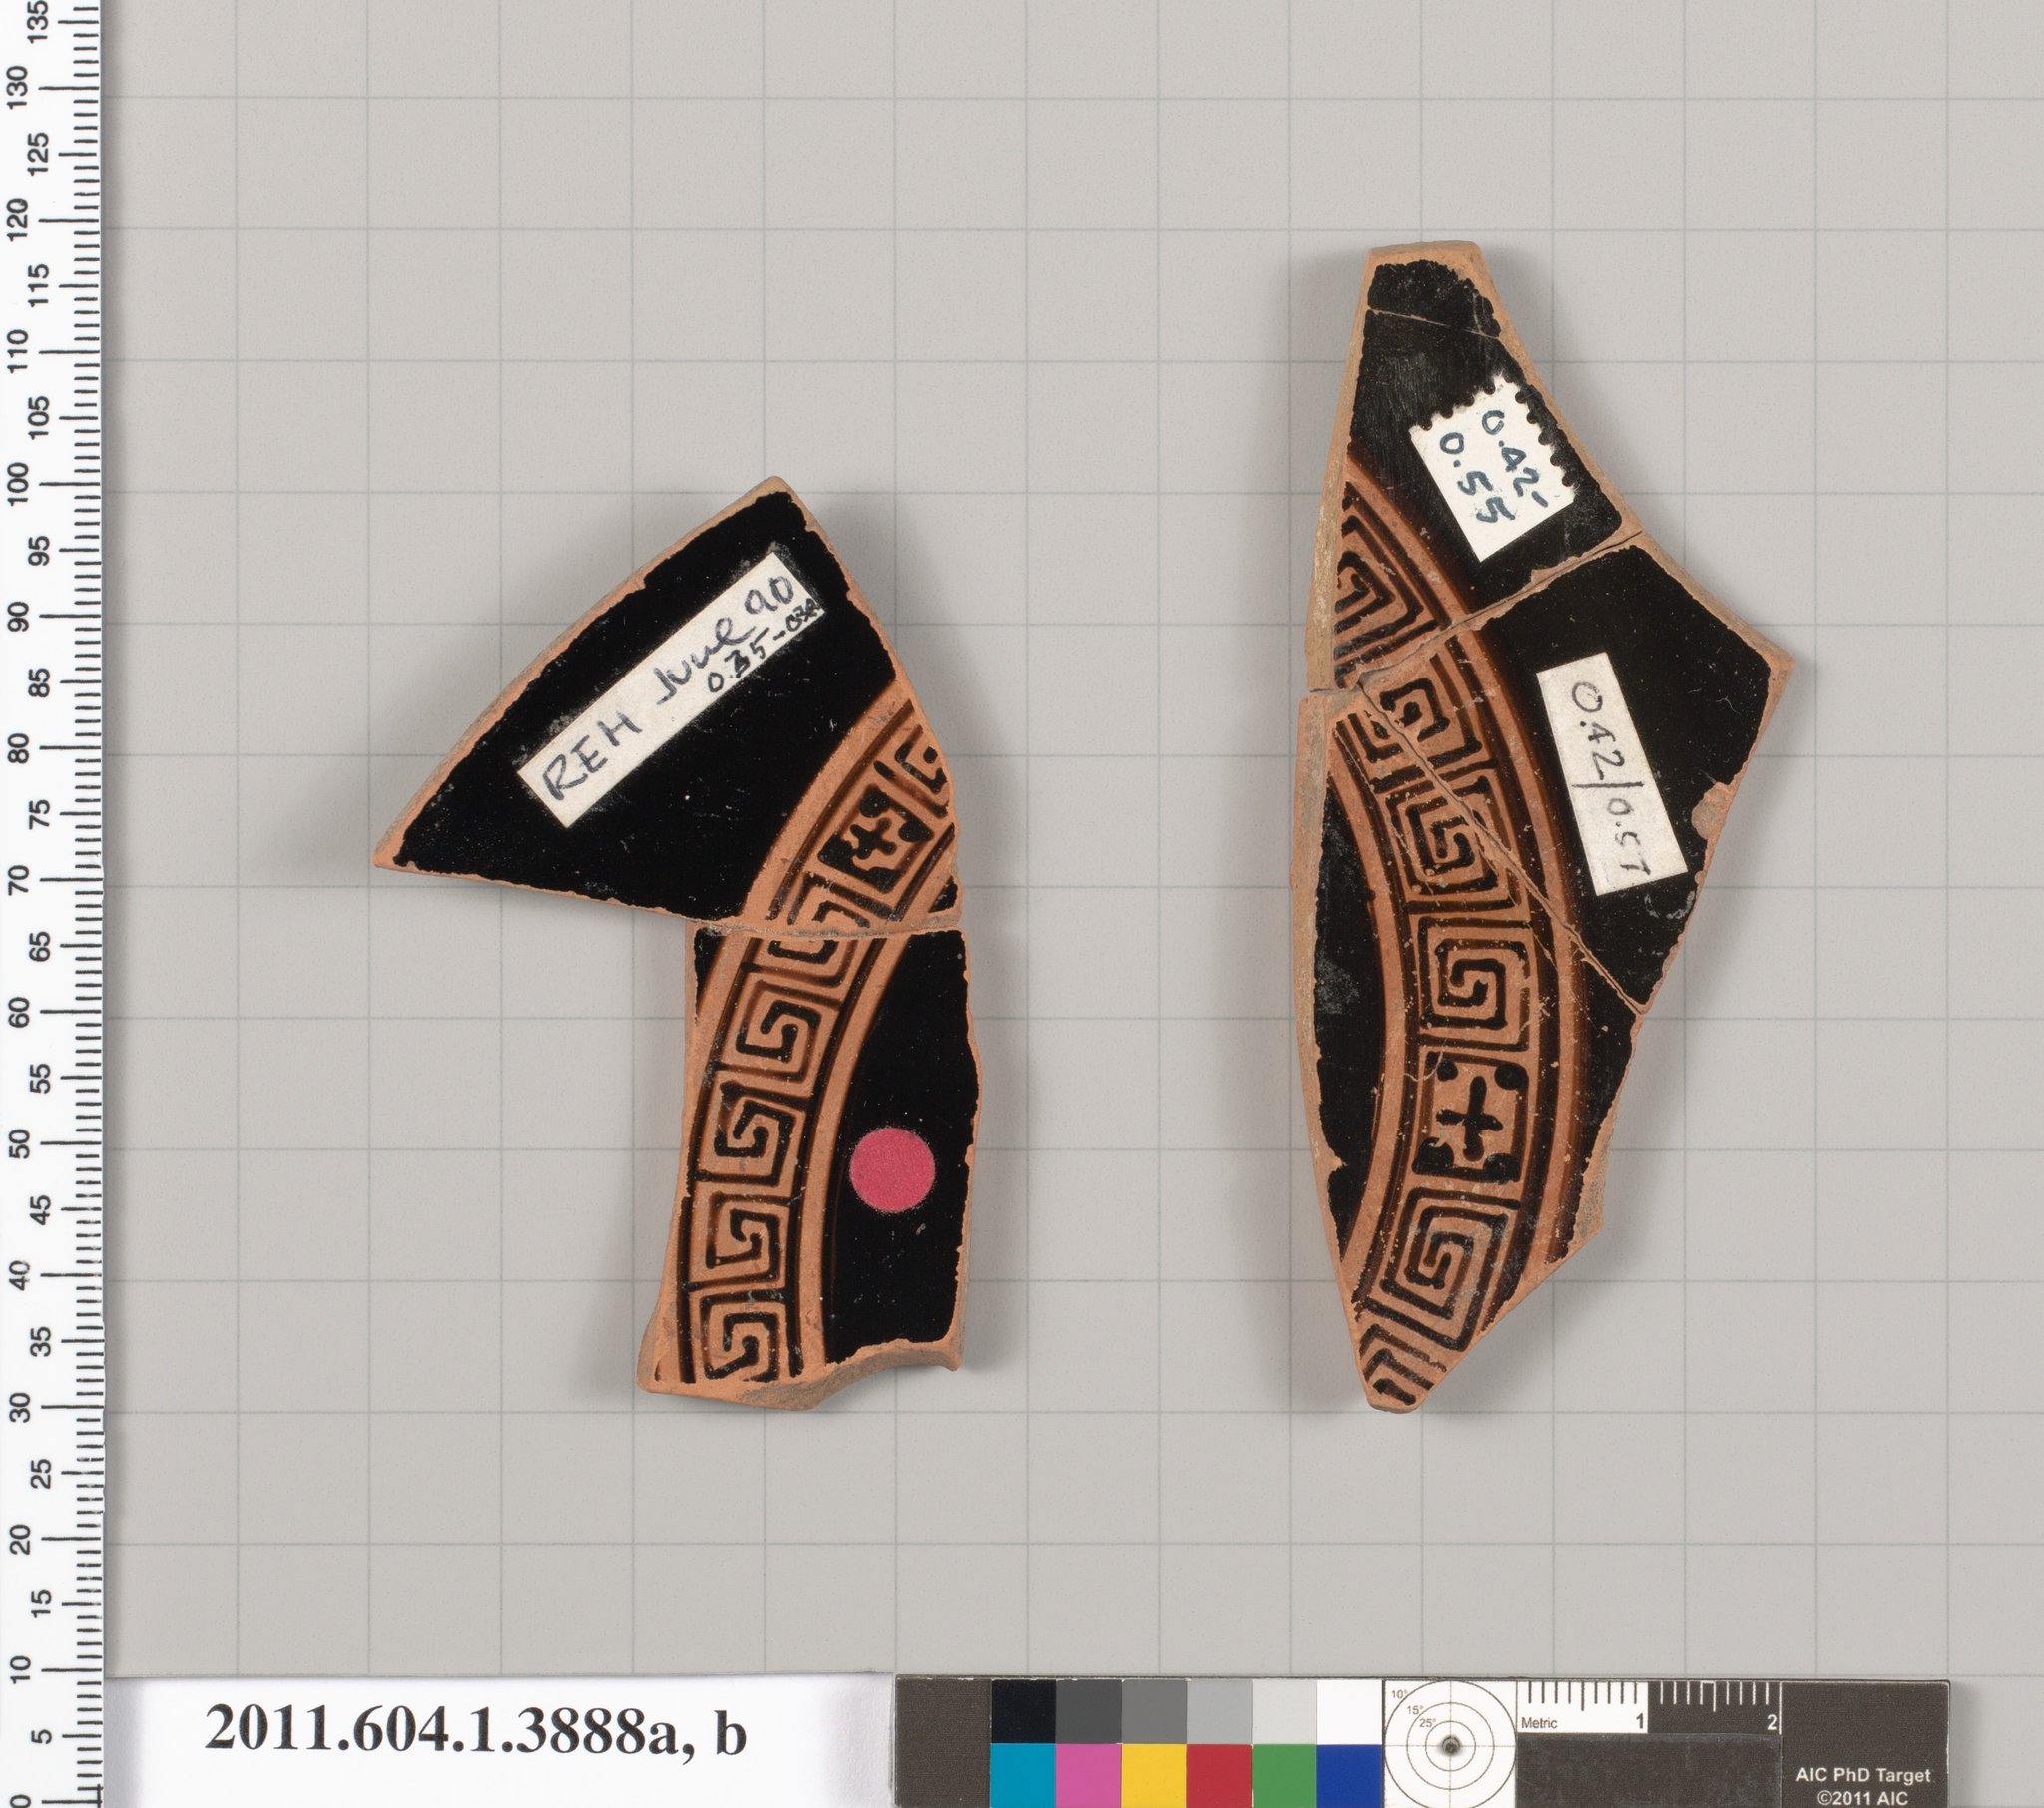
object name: kylix fragment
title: Terracotta fragments of kylikes (drinking cups)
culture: greek, attic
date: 475-451 BCE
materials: terracotta